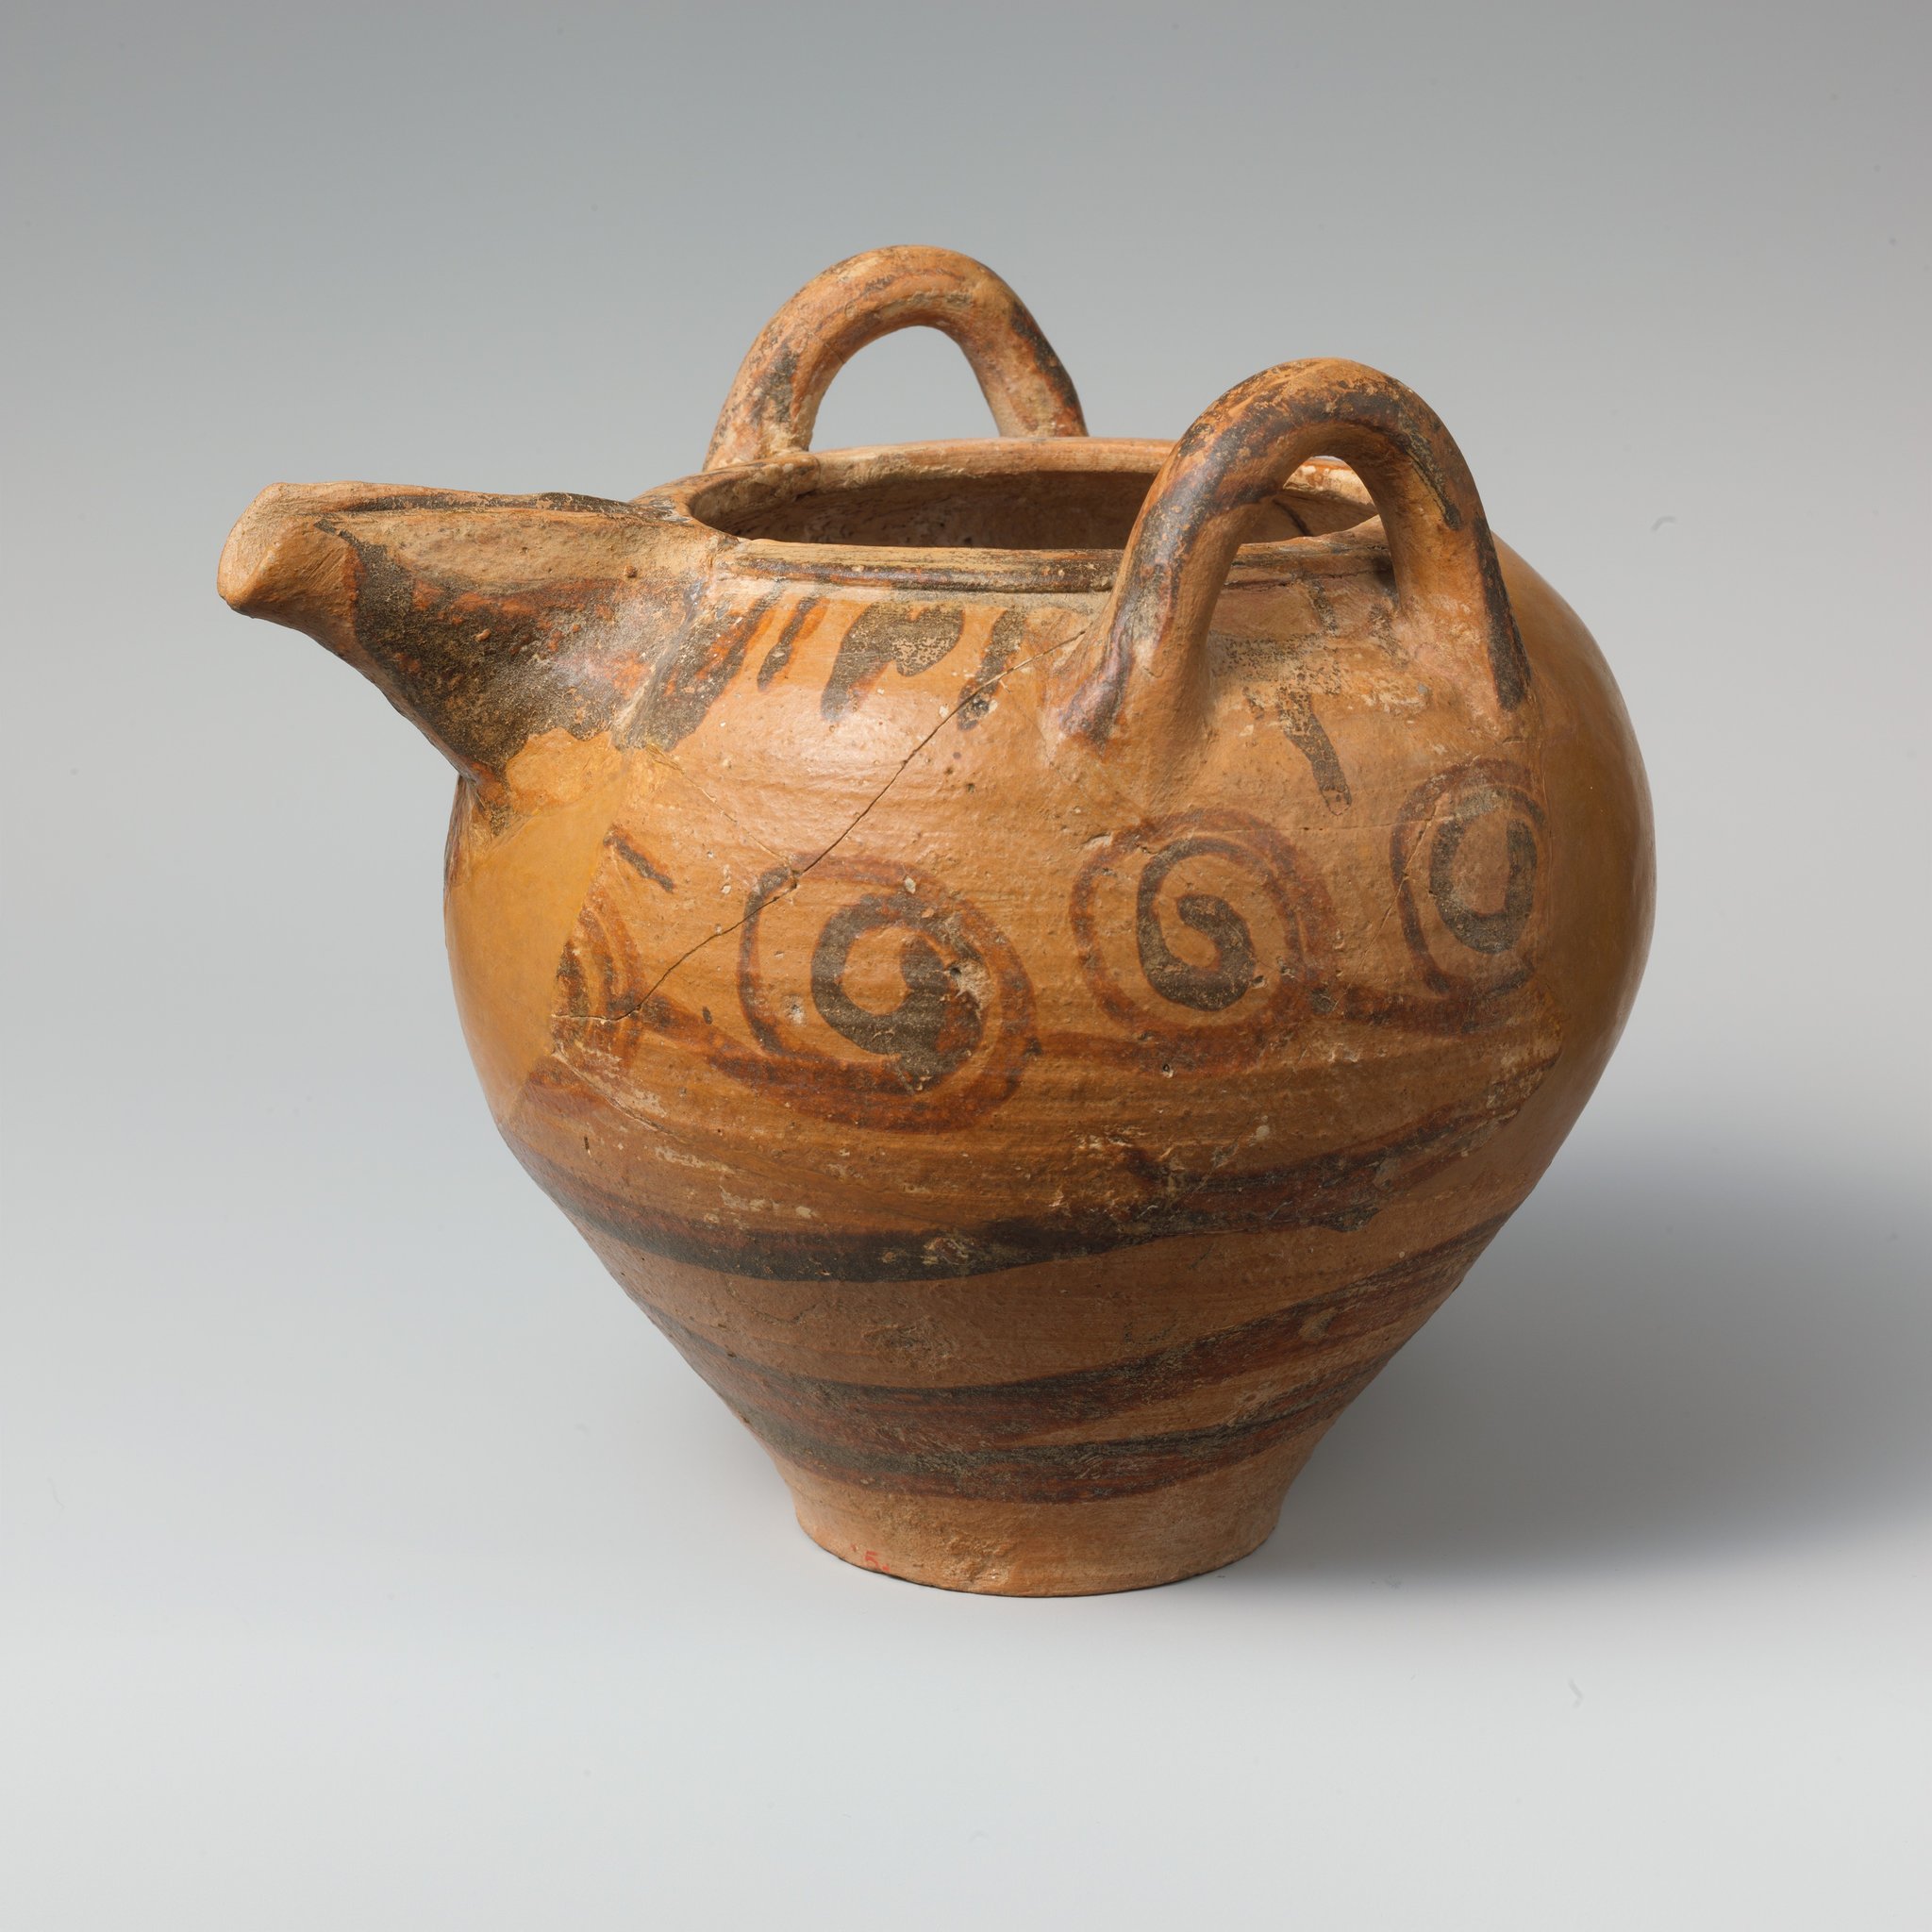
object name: jar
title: Terracotta bridge-spouted jar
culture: minoan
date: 1600-1450 BCE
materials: terracotta